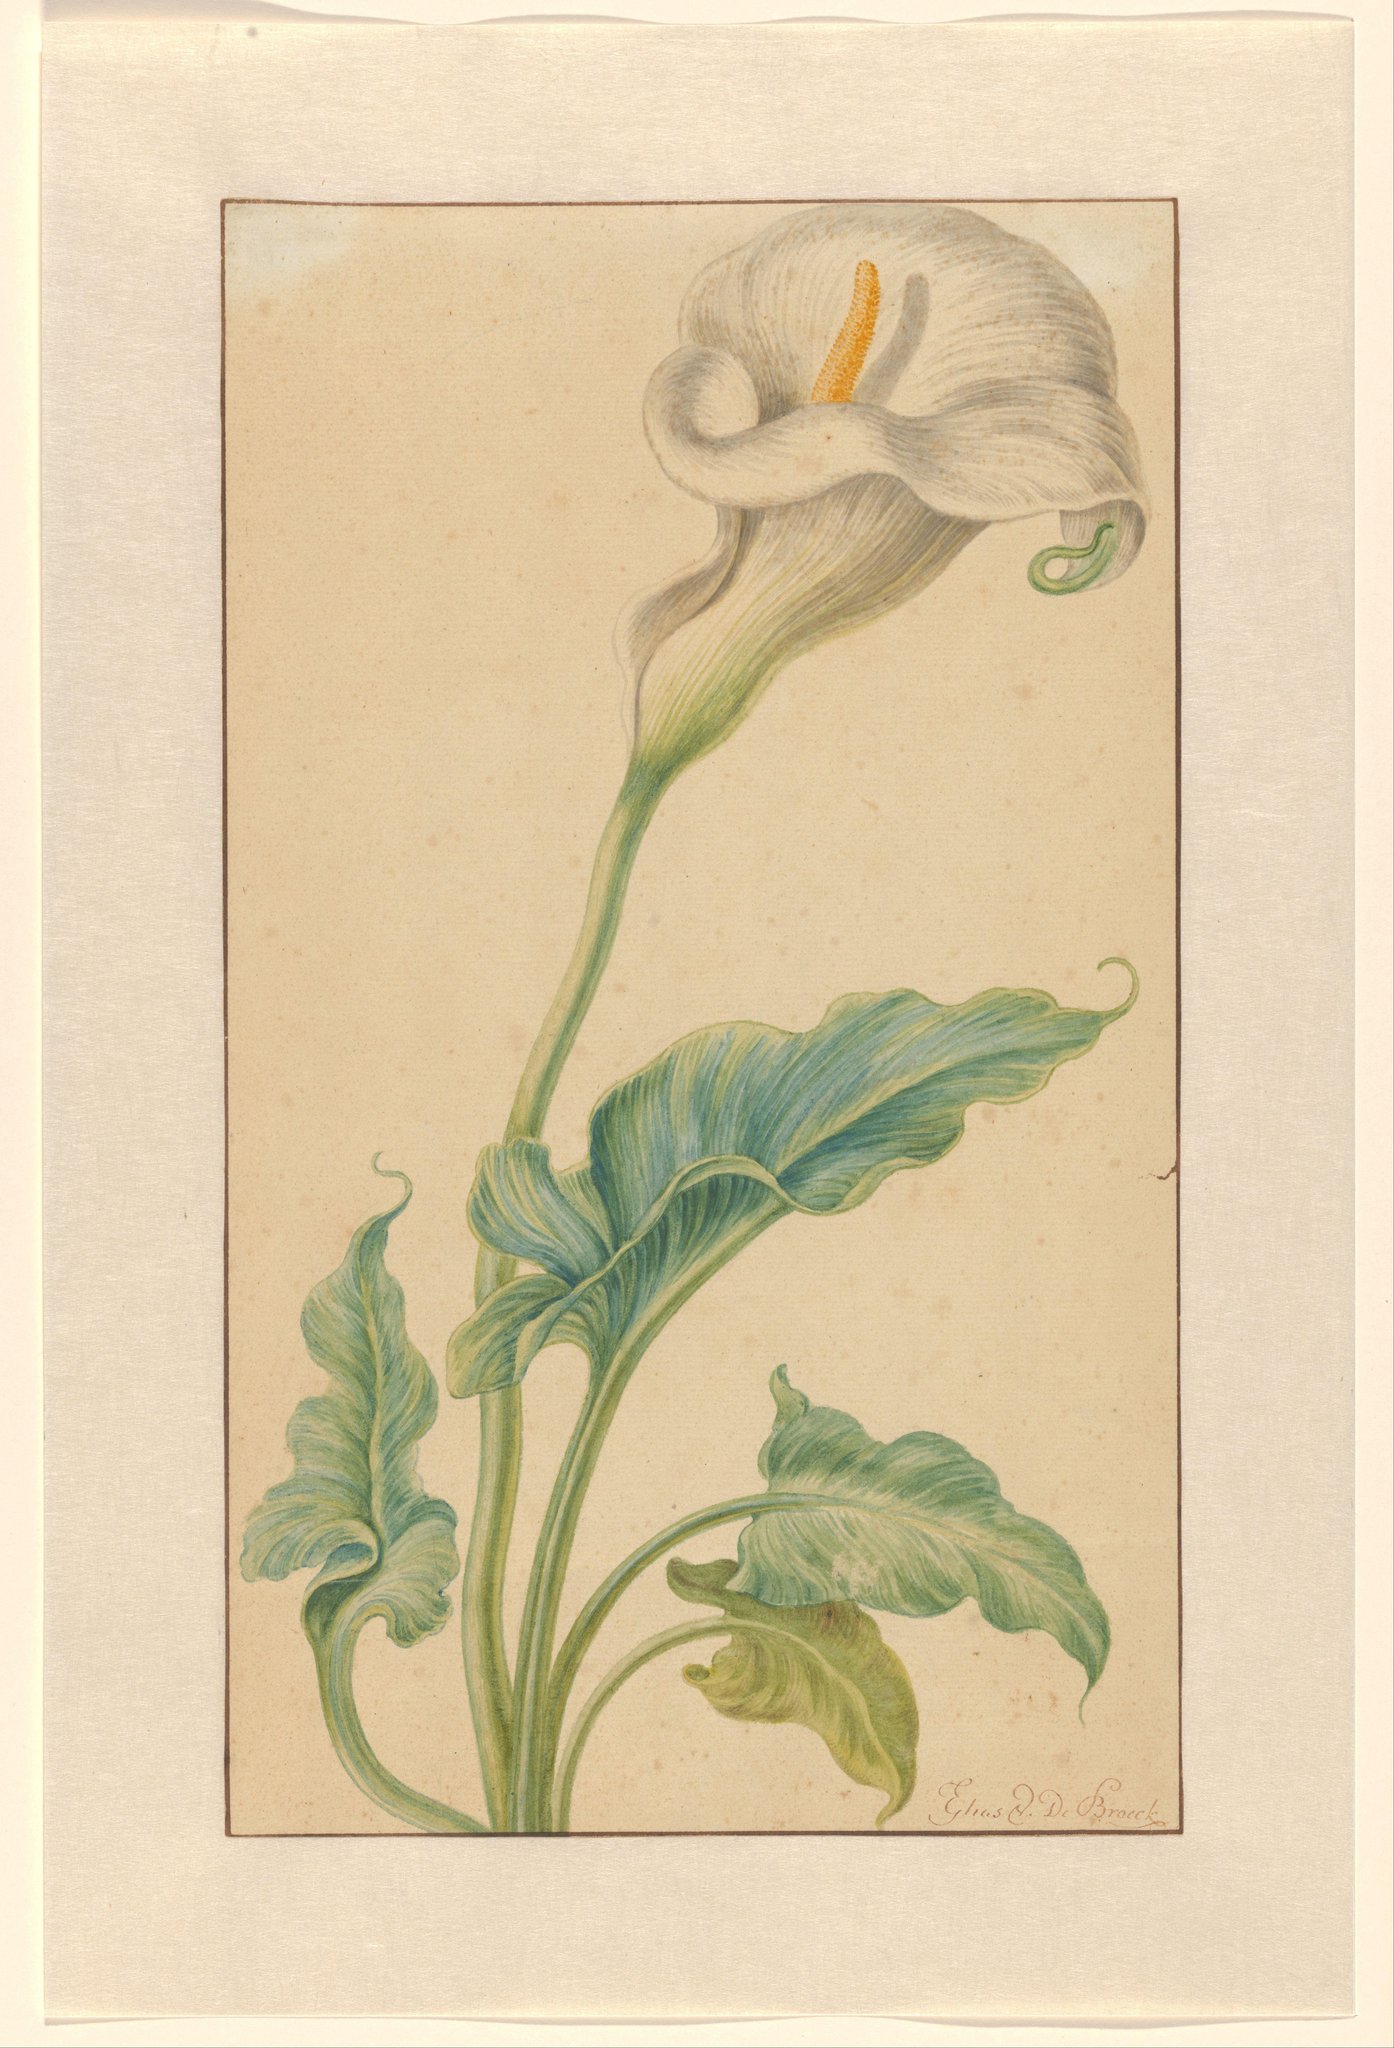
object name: watercolor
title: Witte aronskelk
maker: elias van den broeck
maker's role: painter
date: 1665-1669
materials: paper, watercolor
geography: amsterdam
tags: flowers: arum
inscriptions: signature: ‘Elias v.d. Broeck’